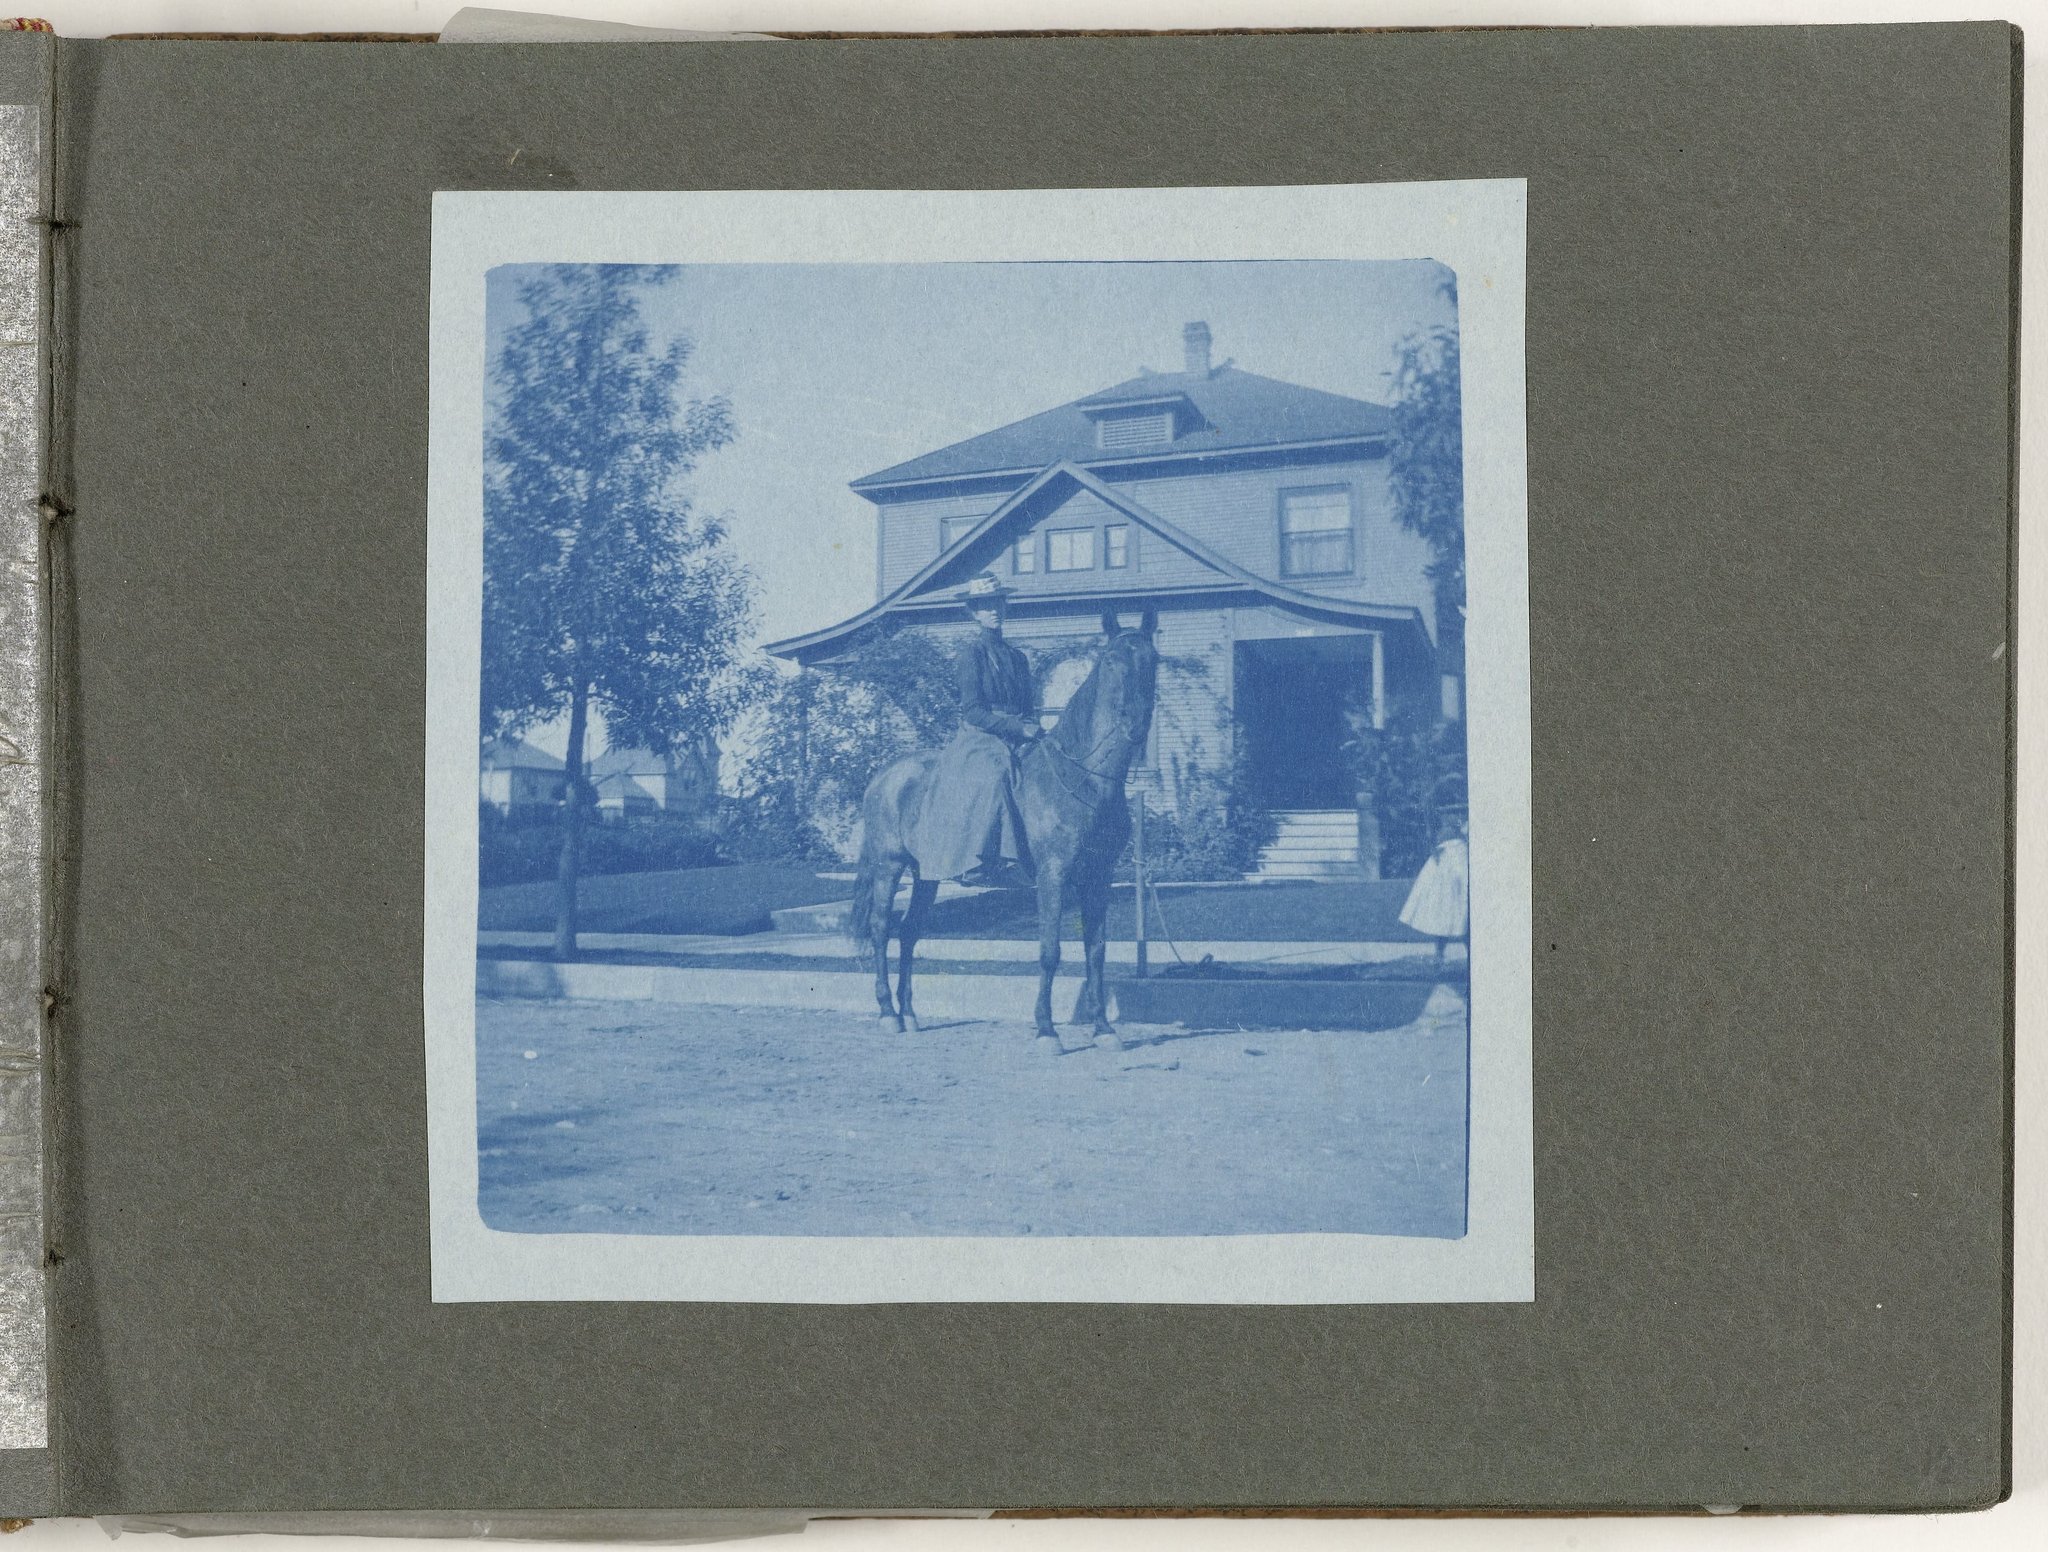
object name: album leaf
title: Portret van een vrouw te paard voor een huis, Verenigde Staten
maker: Anonymous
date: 1900-1920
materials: paper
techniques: cyanotype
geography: united states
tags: riding a horse, ass, or mule; rider, horseman, historical persons not known by name - bb - woman, villa, united states of america